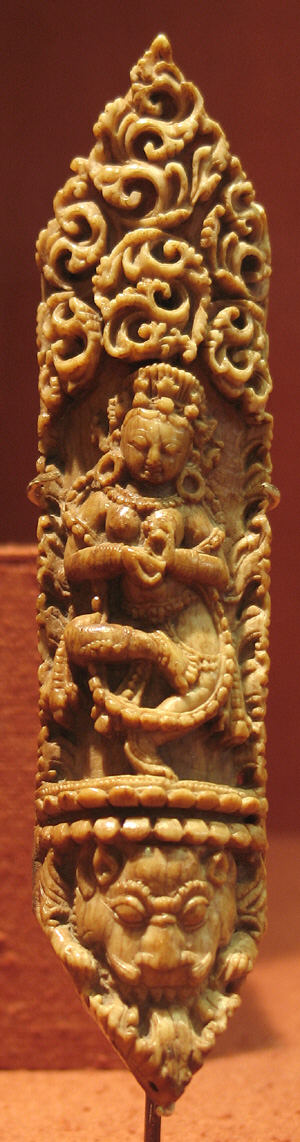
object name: plaque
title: Plaque from a Tantric Ritual Apron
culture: tibetan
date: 1501-1600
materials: bone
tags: human figures